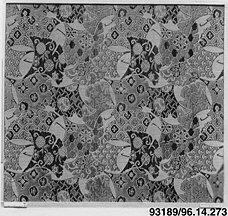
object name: piece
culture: japanese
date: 1701-1900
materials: silk